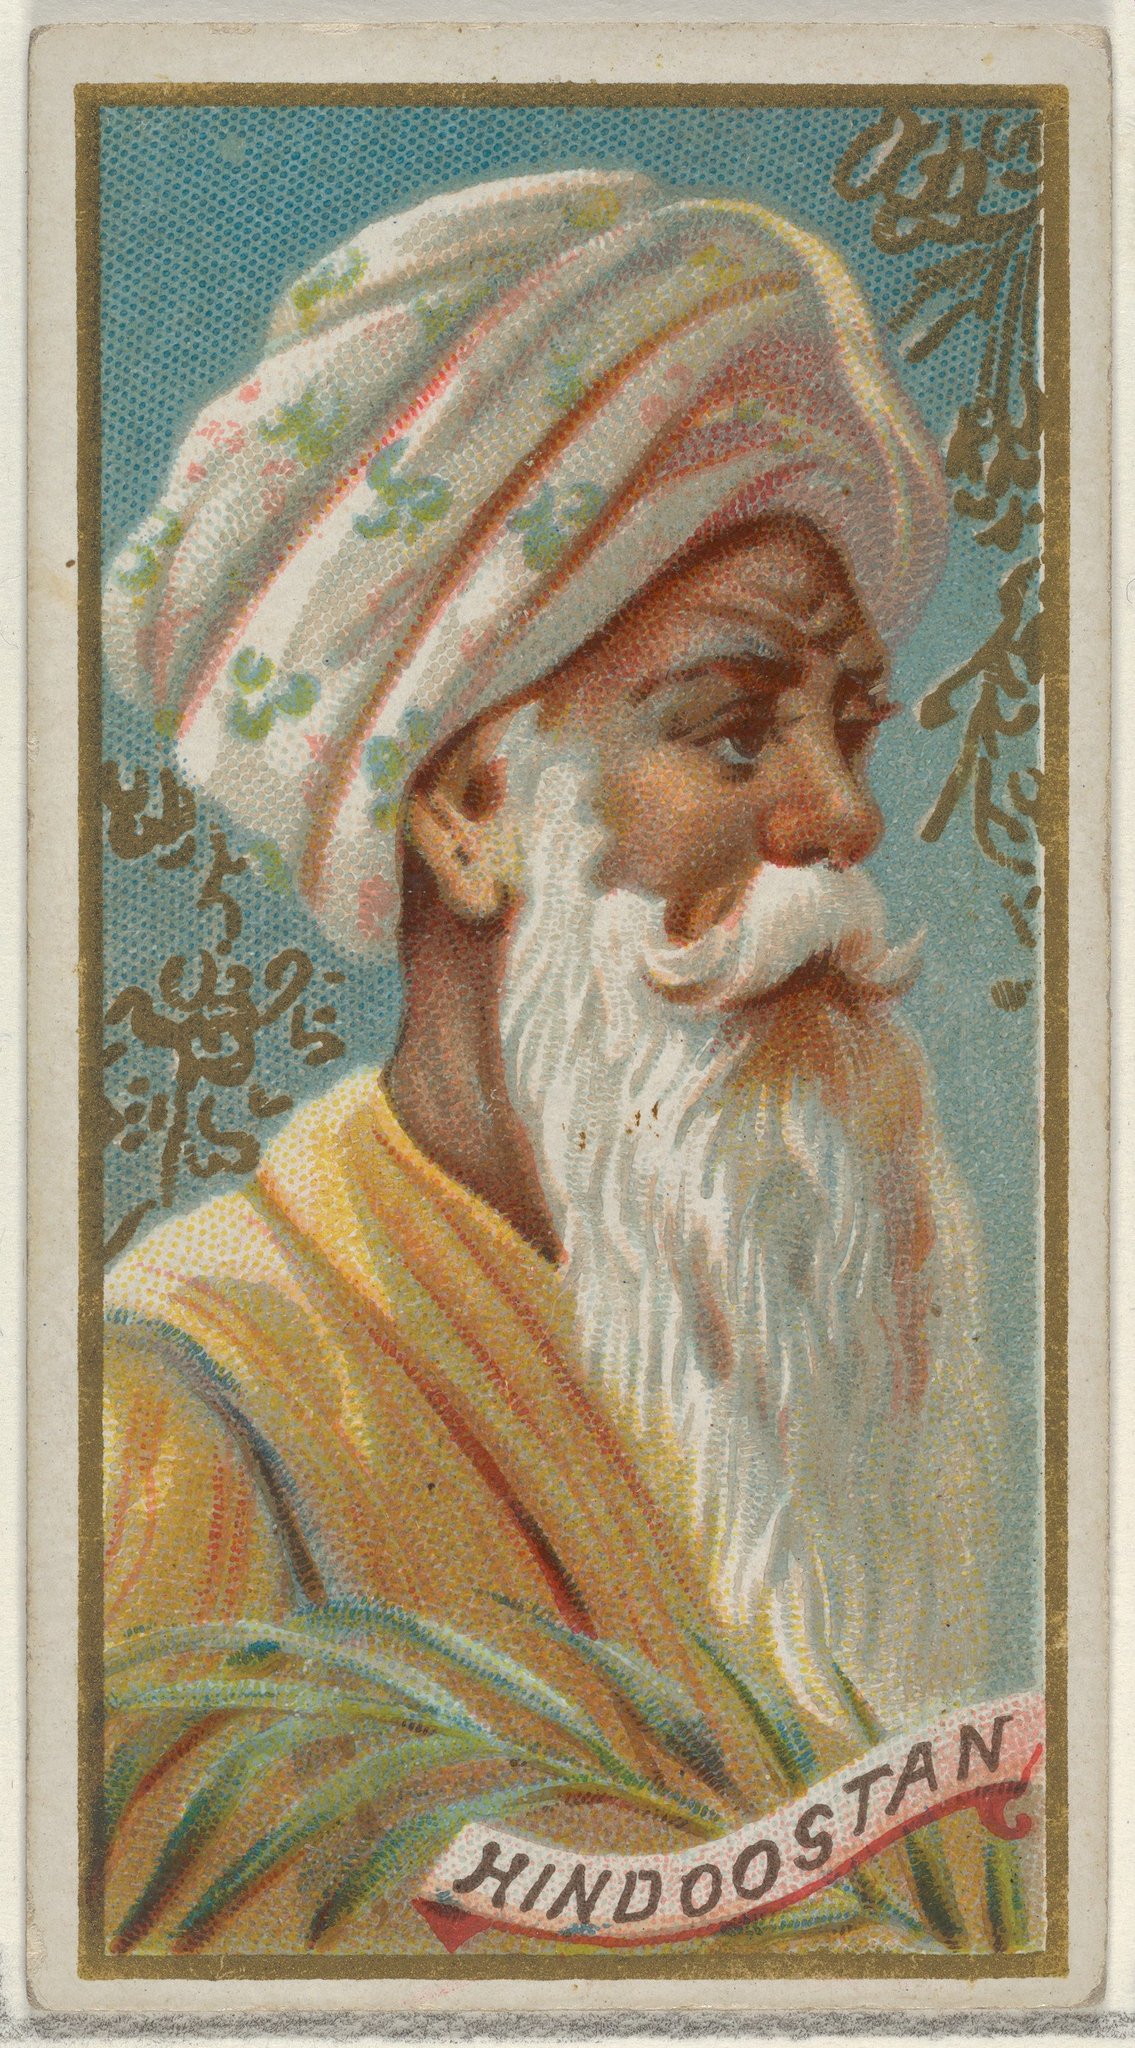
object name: print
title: Hindoostan, from the Types of All Nations series (N24) for Allen & Ginter Cigarettes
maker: allen & ginter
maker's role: publisher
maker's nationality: american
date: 1889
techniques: color lithograph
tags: men